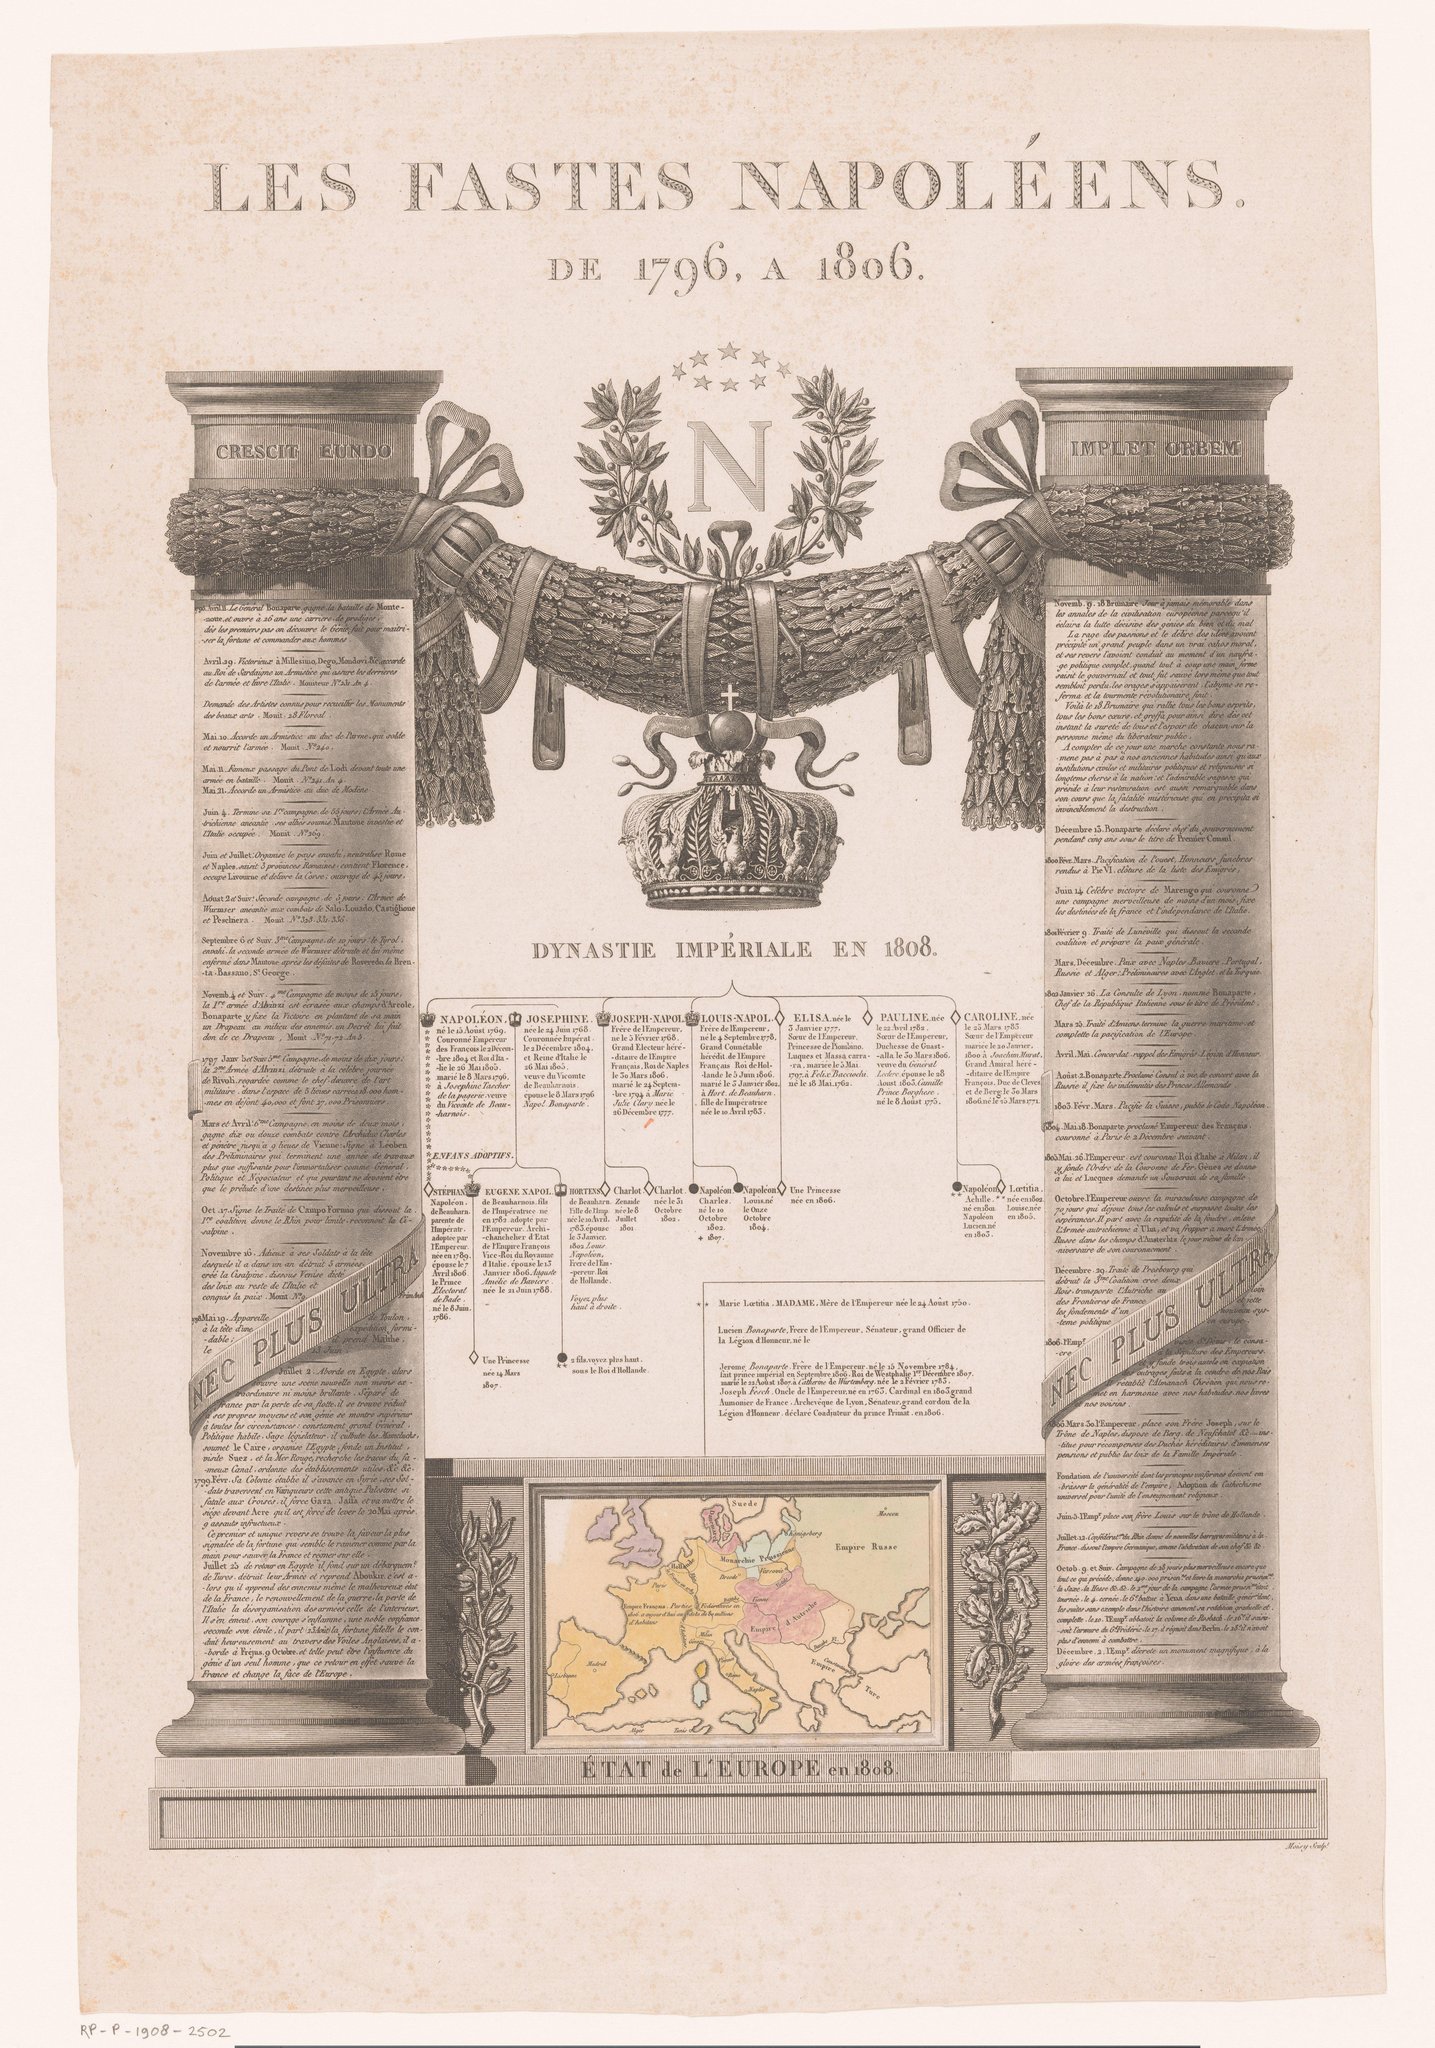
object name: print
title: Daden en prestaties van Napoleon I Bonaparte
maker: alexandre moisy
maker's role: print maker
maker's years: 1763-1827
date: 1808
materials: paper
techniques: aquatint, etching, hand coloring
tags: napoleon i (emperor of the french), crown (symbol of sovereignty), column, pillar ~ architecture, family lineage, pedigree, genealogical tree or table, emperor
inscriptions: collector's mark: Lugt 2228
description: Op twee zuilen, verbonden door de keizerlijke kroon, staan de data van de belangrijke prestaties en daden van Napoleon tussen 1796-1806 gedrukt. Tussen de pilaren, in het midden, bevindt zich een stamboom van de keizerlijke dynastie, met onderaan een kaart van het Franse keizerrijk in 1808.